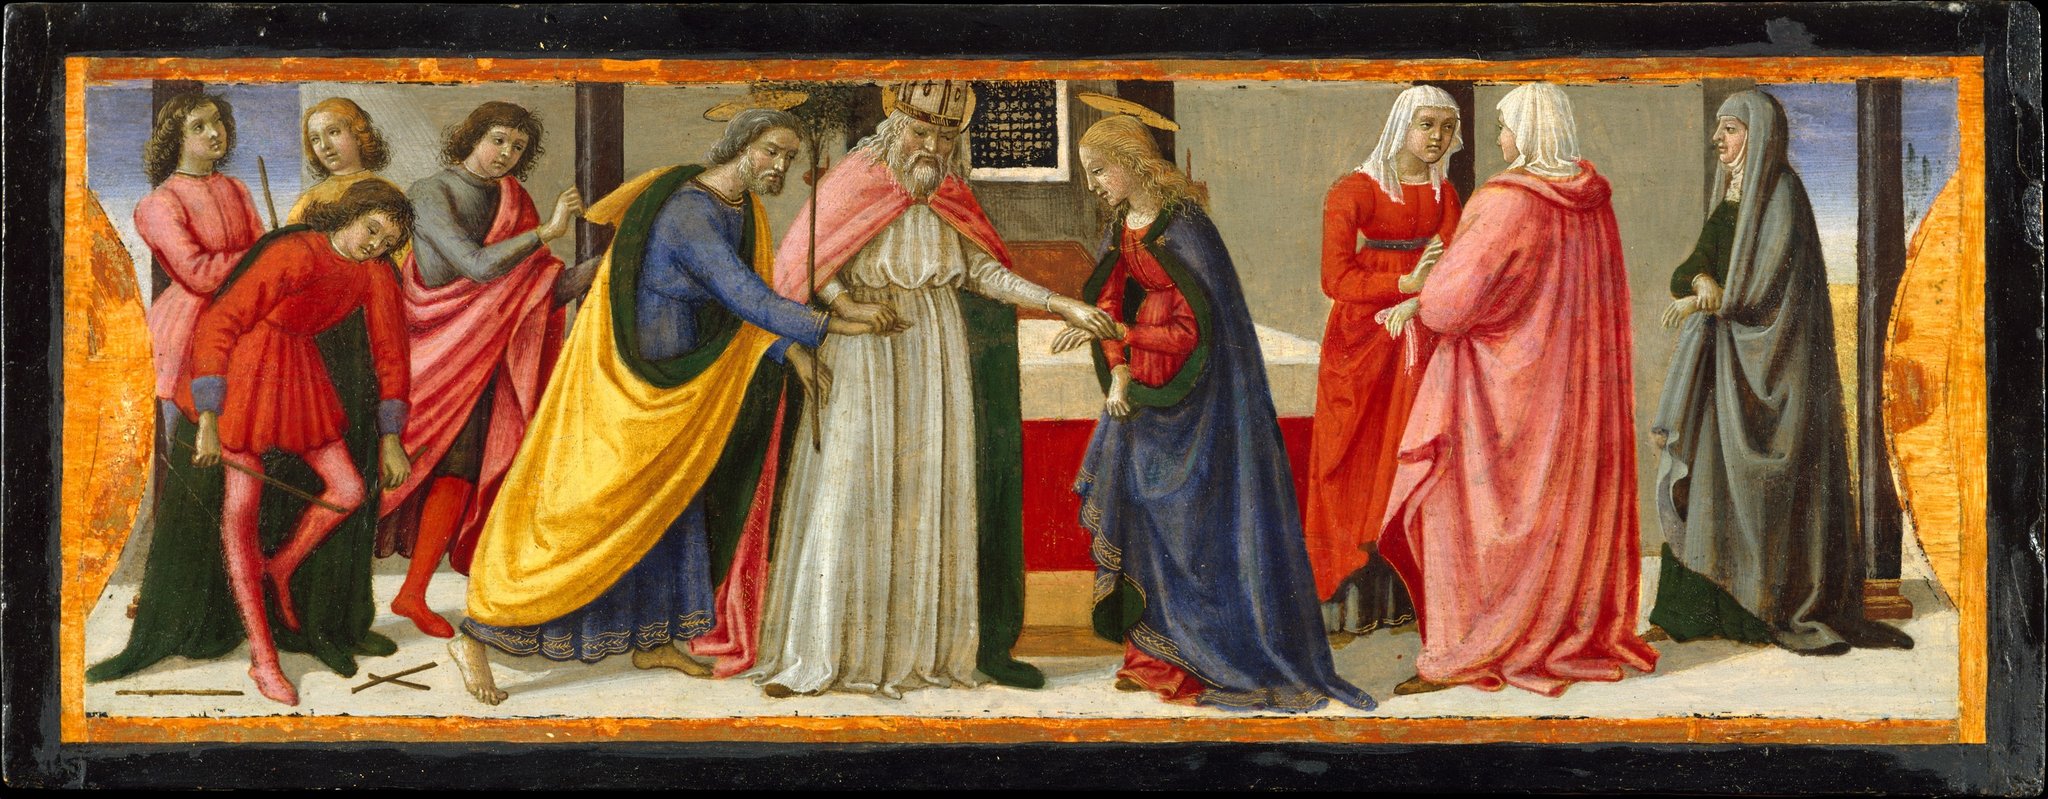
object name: painting, predella panel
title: The Marriage of the Virgin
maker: davide ghirlandaio (david bigordi)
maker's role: artist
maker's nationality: italian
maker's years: 1452-1525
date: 1479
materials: gold, paint, wood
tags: men,women,virgin mary